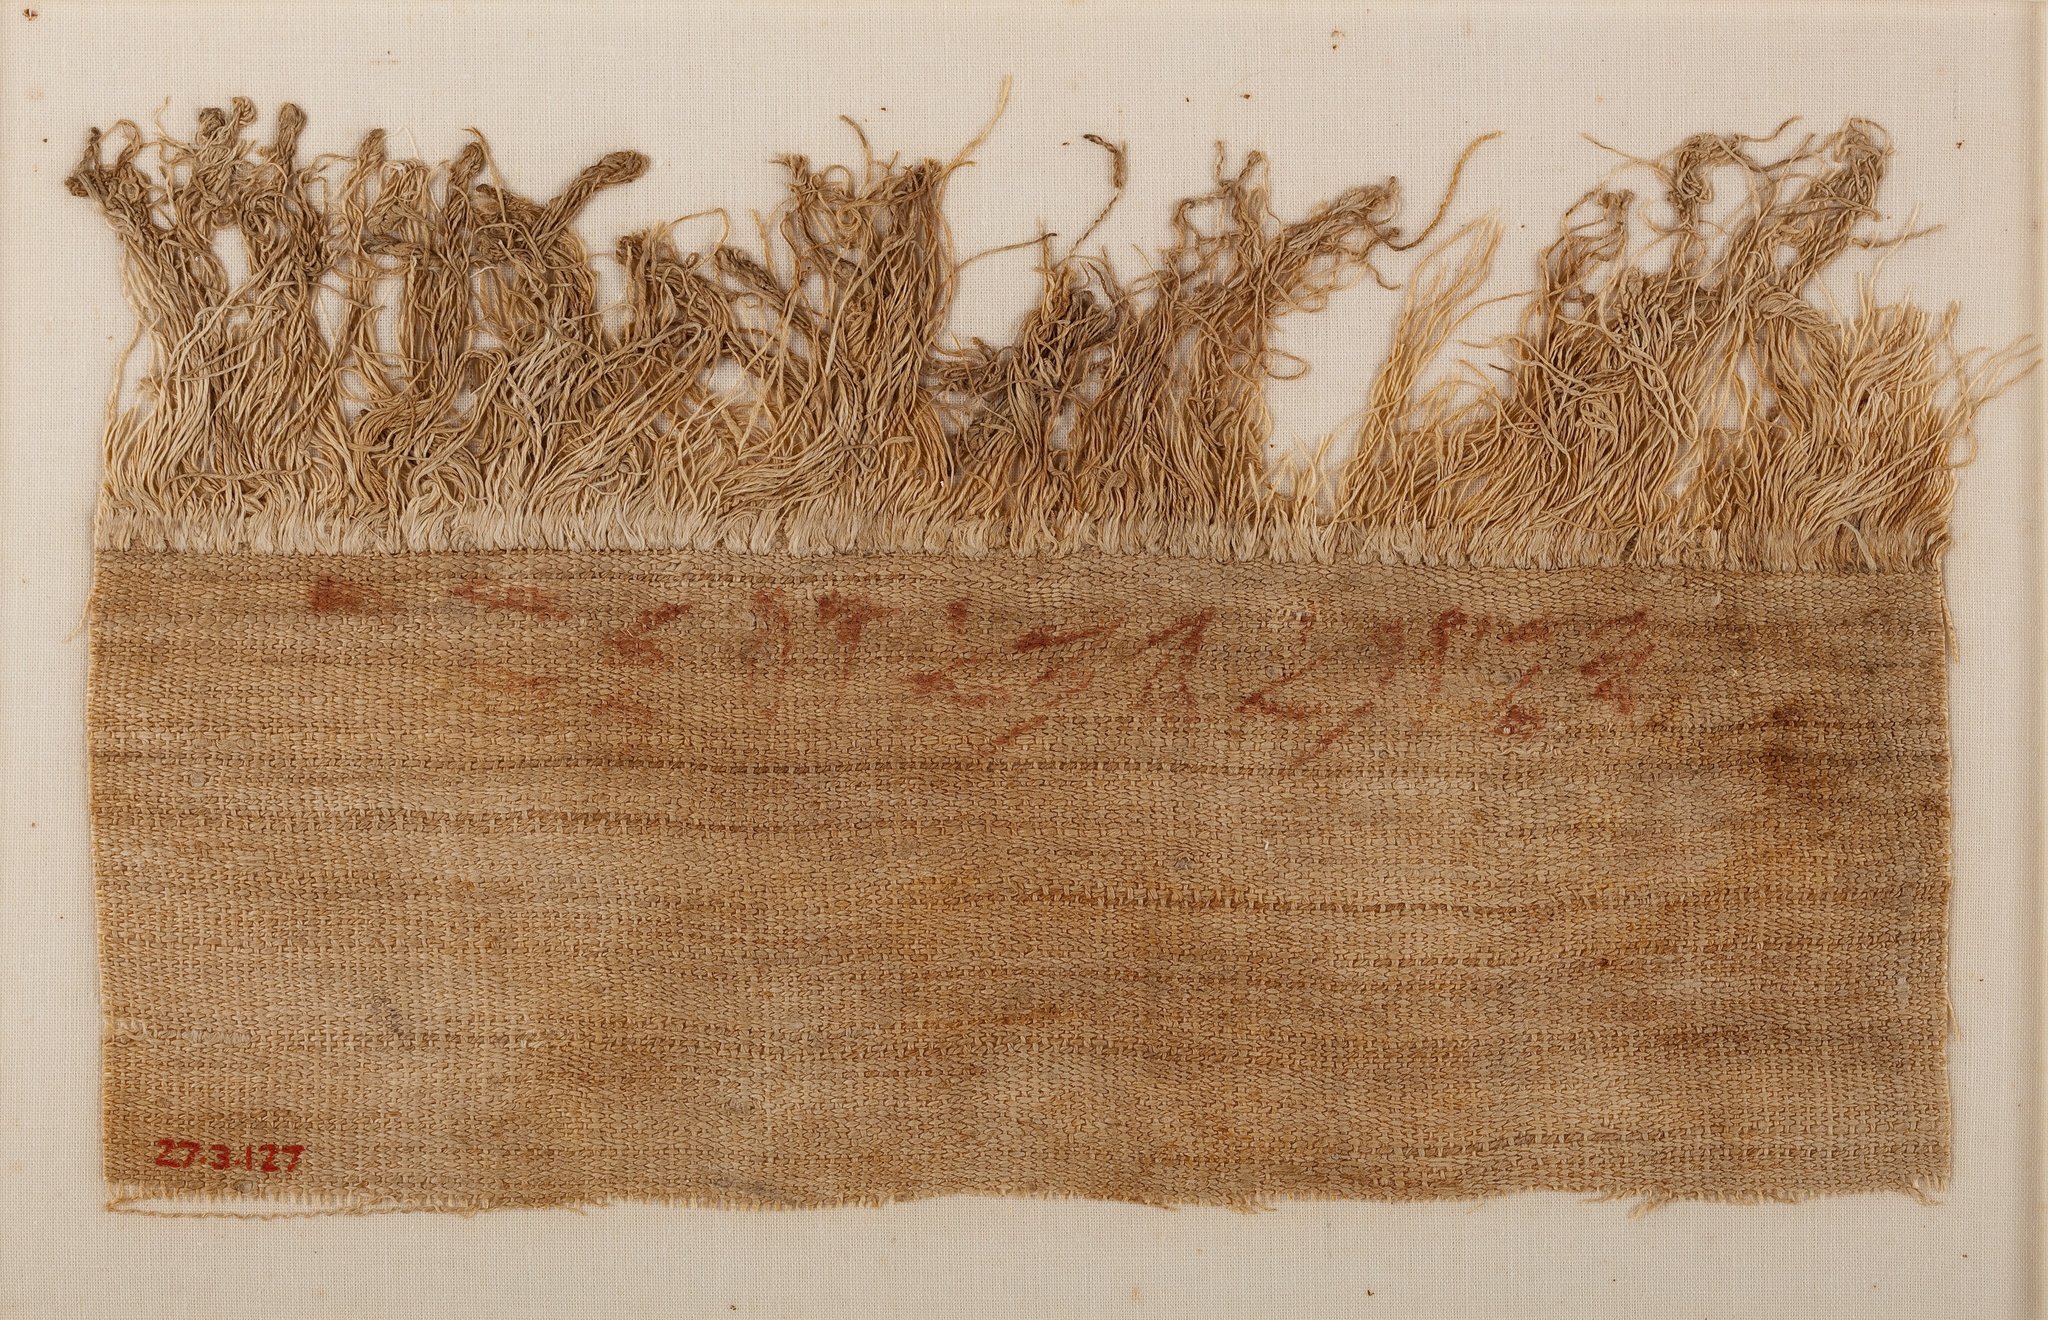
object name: linen mark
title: Linen mark (Type XXIX)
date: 1961-1917 BCE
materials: linen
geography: egypt